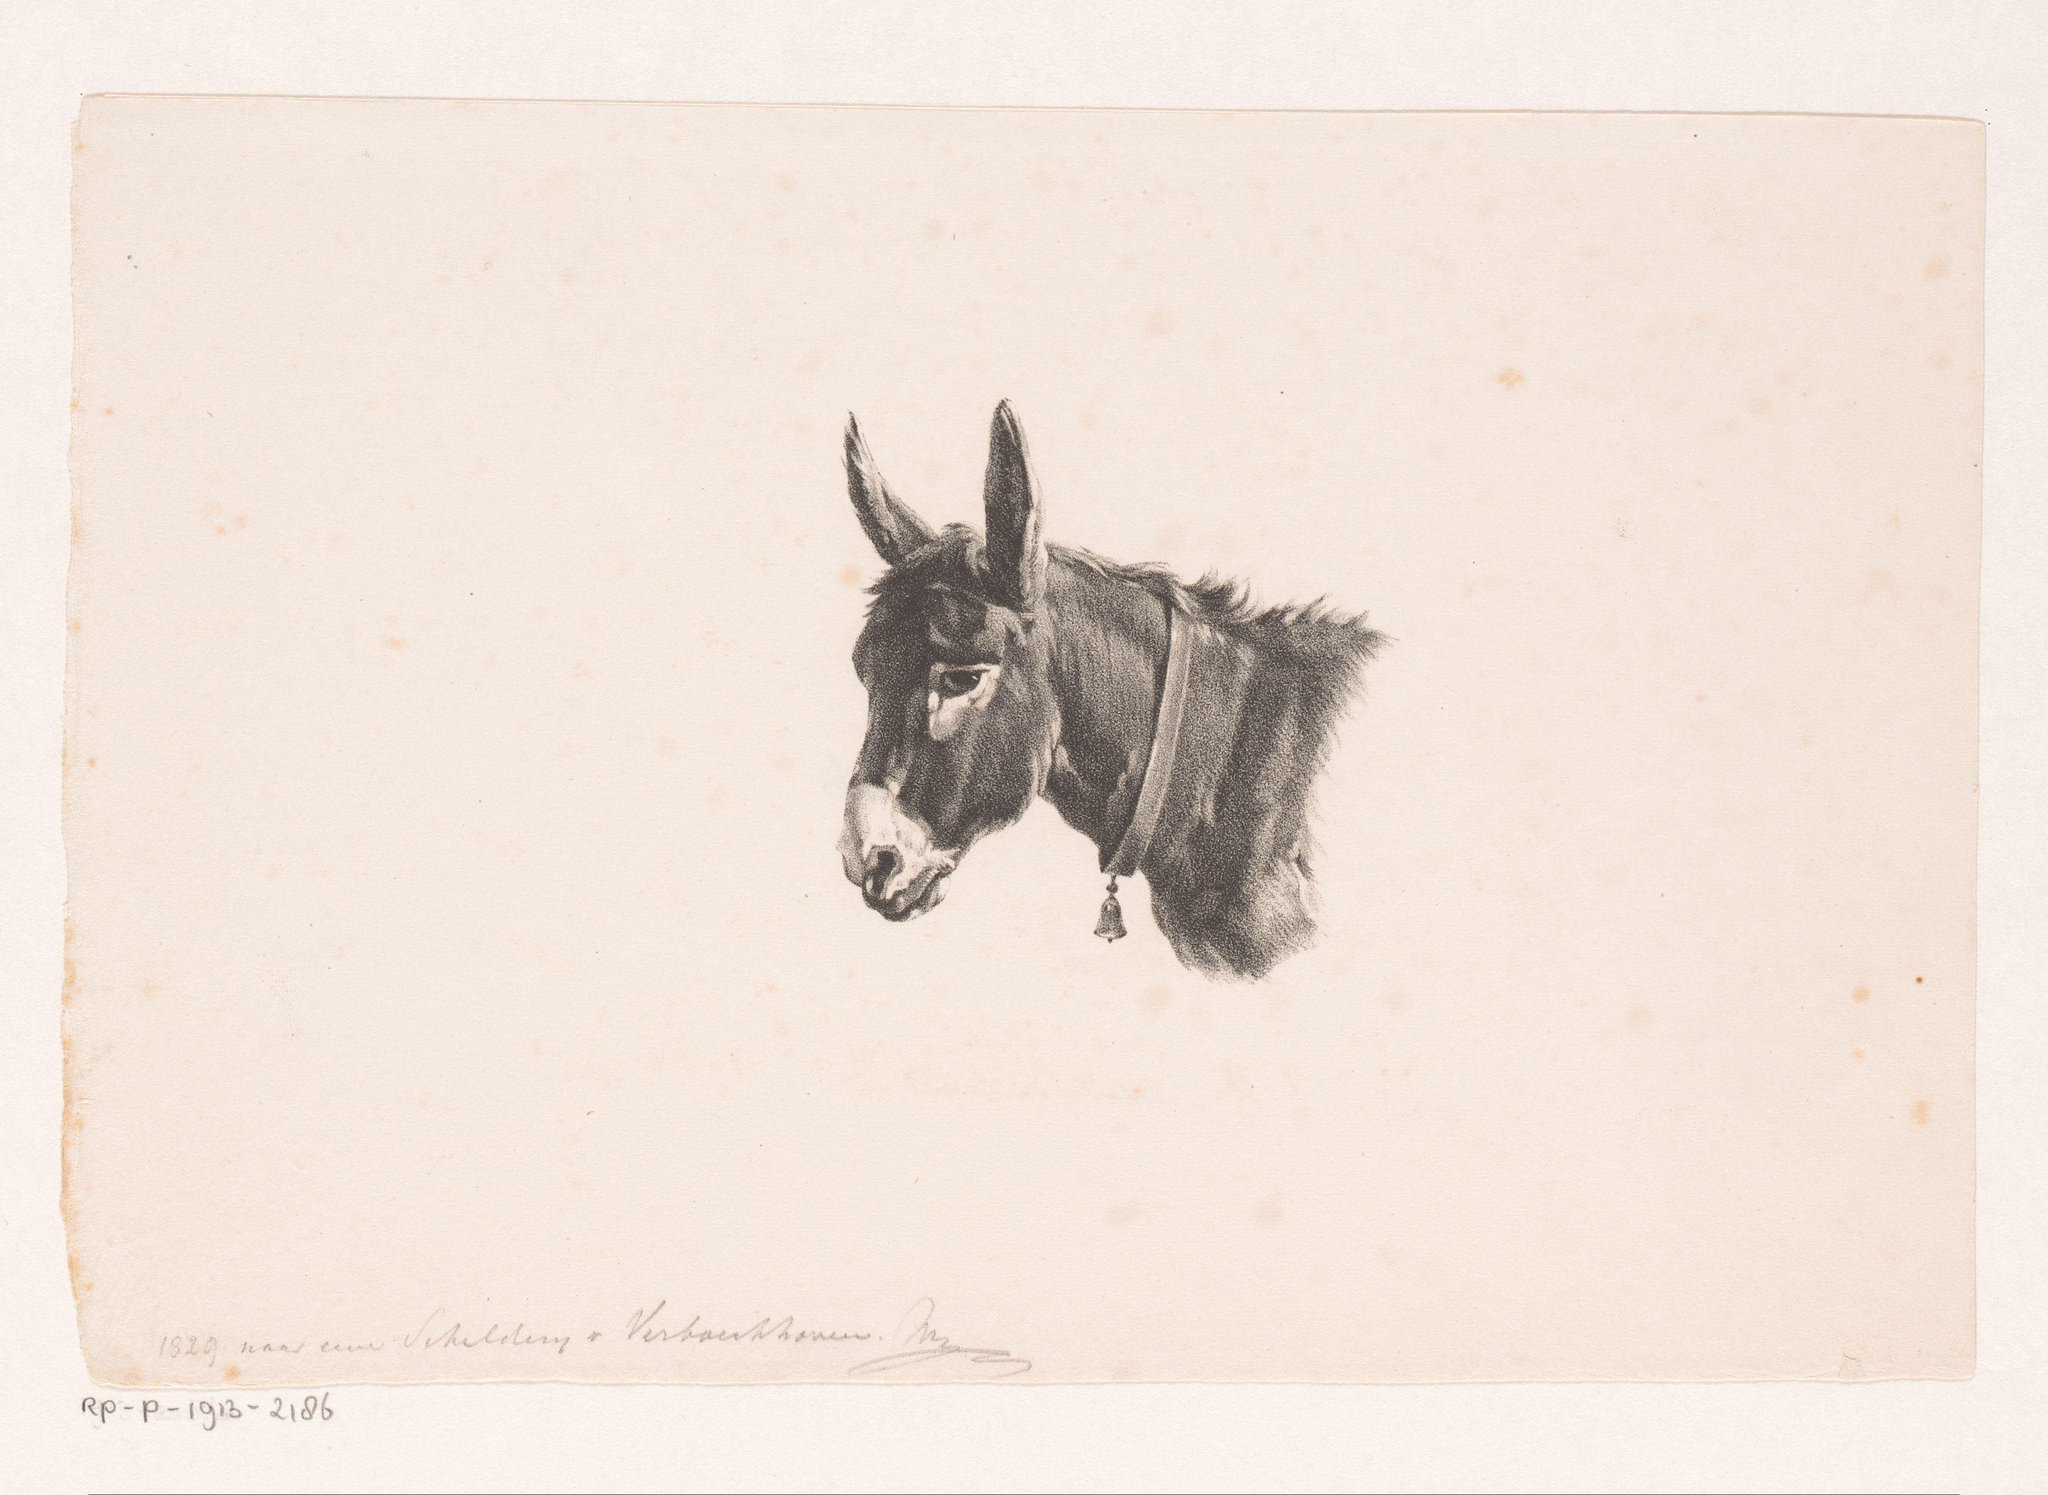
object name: print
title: Ezel met bel om zijn hals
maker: jean zacherie mazel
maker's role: draughtsman, print maker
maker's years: 1792-1884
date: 1829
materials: paper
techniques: lithograph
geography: the hague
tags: ass, donkey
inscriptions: collector's mark: Lugt 2233, inscription: ‘1829 naar een schilderij v Verboeckhoven’